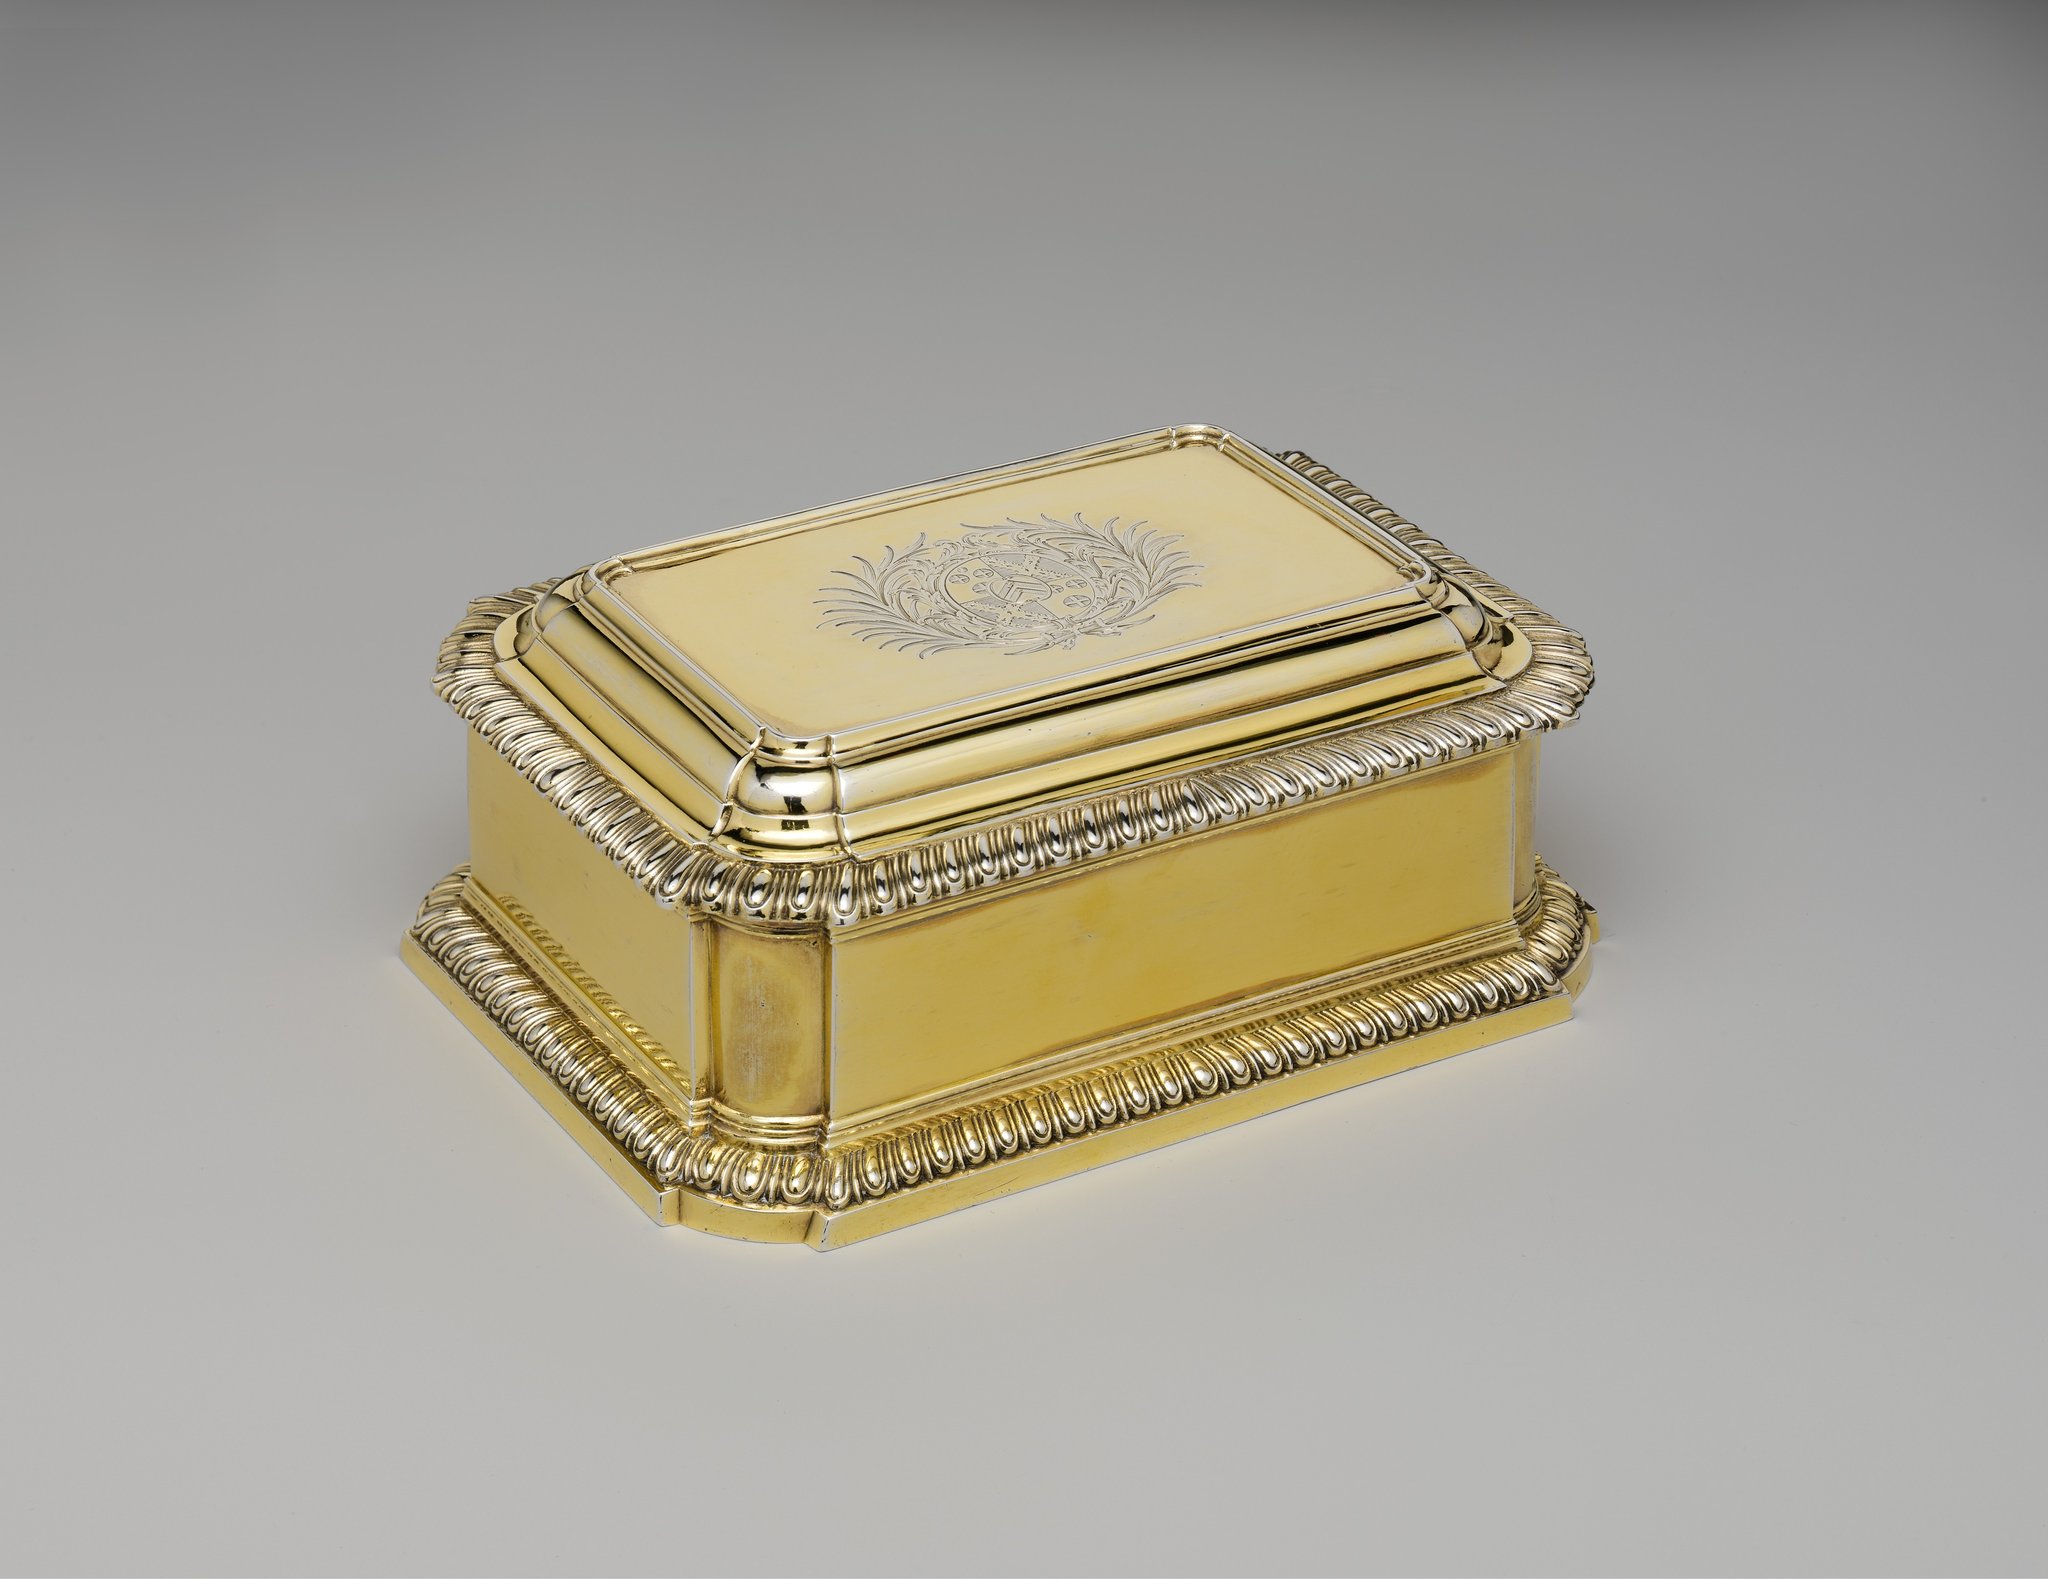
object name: box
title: Box (one of a pair) (part of a set)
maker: john parker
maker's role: maker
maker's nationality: british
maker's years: 1759-1777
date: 1766-1767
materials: silver gilt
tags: coat of arms